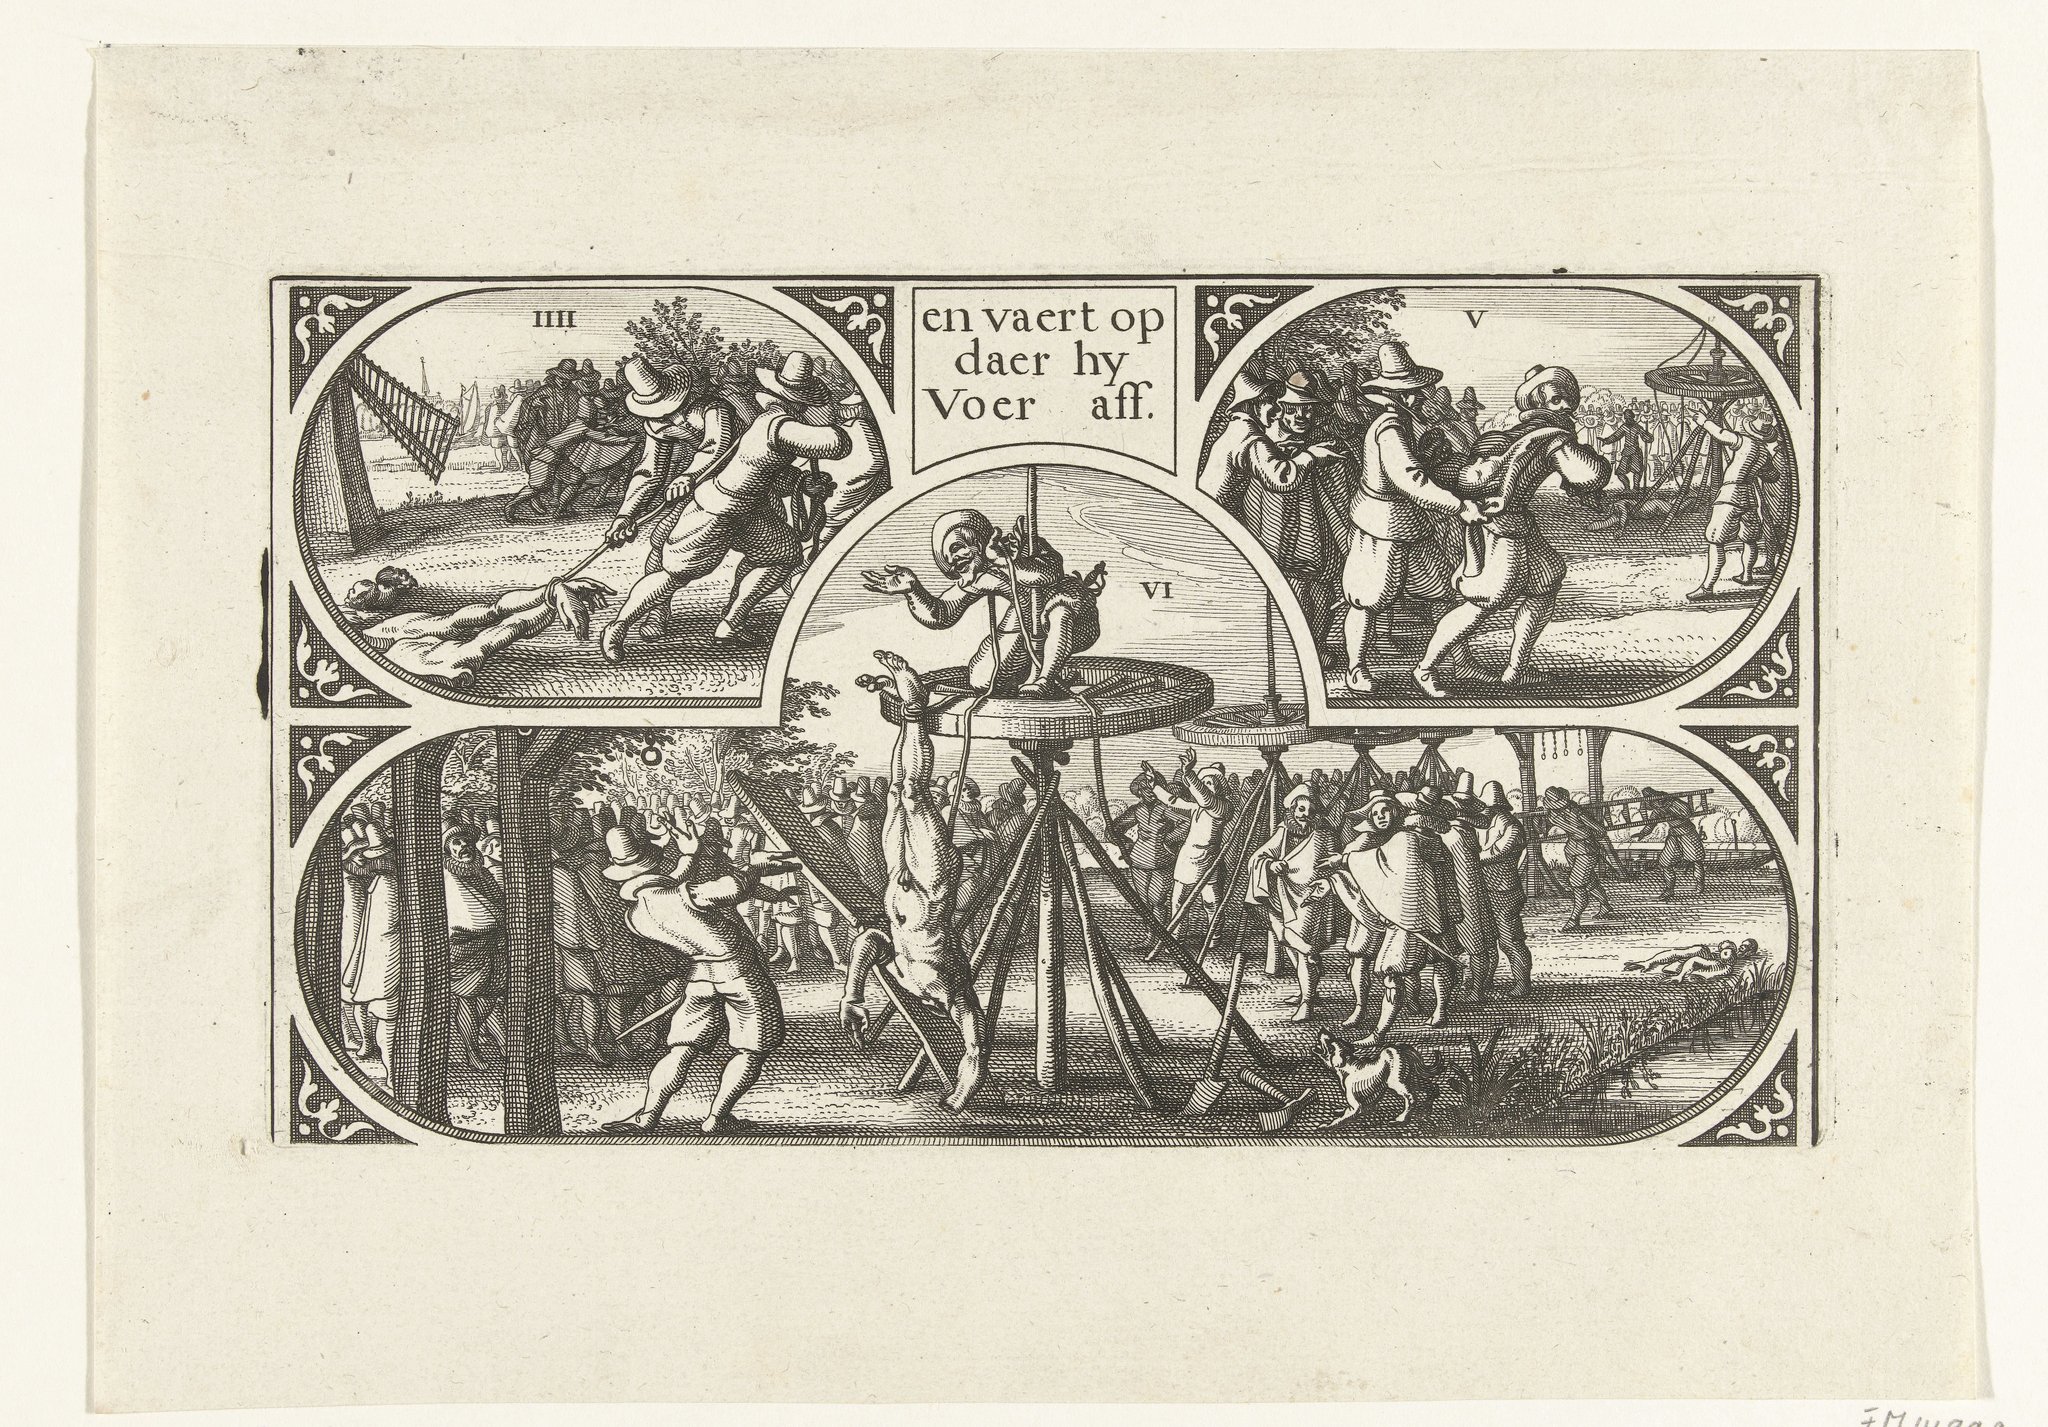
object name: print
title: Het wegslepen en weer ophangen van de lichaamsdelen van Slatius, Coorenwinder en Gerrits, 1623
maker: claes jansz. visscher (ii)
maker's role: draughtsman, print maker, publisher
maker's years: 1586-1652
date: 1623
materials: paper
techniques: etching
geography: amsterdam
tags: maurice (prince of orange), the hague, mutilation of the corpse, arrest (of criminal)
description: Het wegslepen en weer ophangen van de lichaamsdelen van Henricus Slatius, David Coorenwinder en Cornelis Gerrits, veroordeelde samenzweerders tegen Maurits, terechtgesteld in februari, maart en mei 1623 te Den Haag. De scènes genummerd IIII-VI van het terugslepen van de lichamen naar het galgenvelden het weer ophangen aan het rad. Afdruk van de onderste helft van de oorspronkelijke - nu in tweeën gesneden - plaat, zonder teksten. Met het opschrift: en vaert op daer hy voer aff.